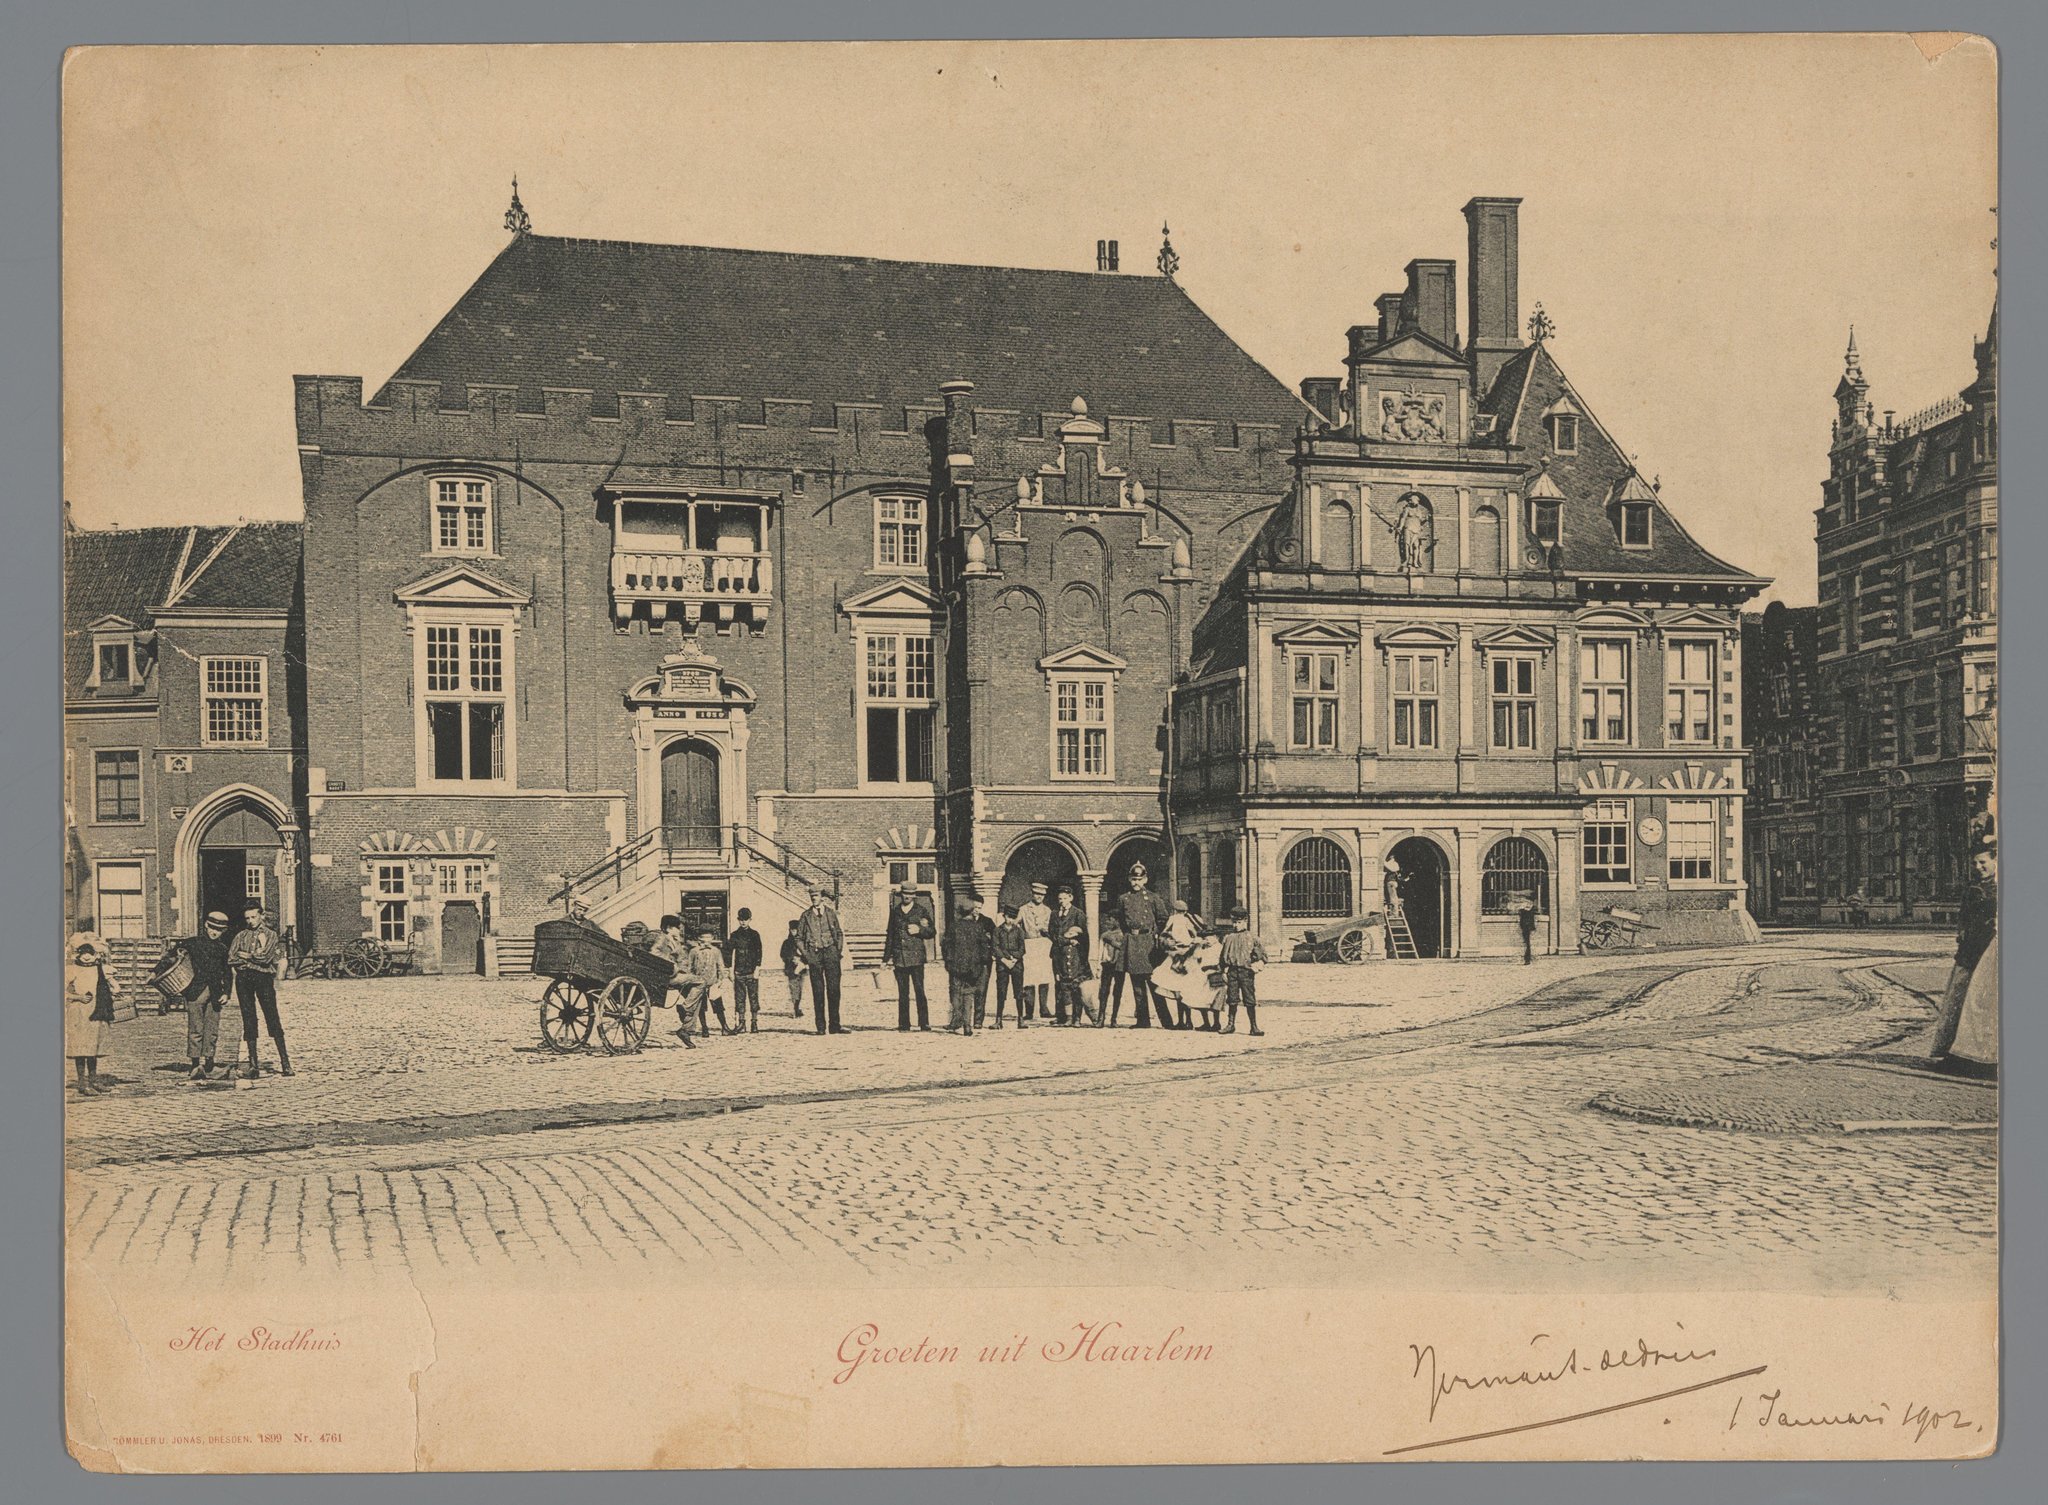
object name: ansichtkaart, prentbriefkaart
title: Gezicht op het Stadhuis in Haarlem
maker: Anonymous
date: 1899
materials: cardboard, paper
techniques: photograph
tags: townhall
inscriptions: annotation: ‘Naam van afzender en datering (1 januari 1902).’, address: ‘Den weled. gest. Heer W.B.G. Molkenboer Directeur Rijksnormaalschool voor Teekenonderwijzers. 50 Vossiusstraat Amsterdam’, inscription: ‘Reuzenkaart drukwerk’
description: Gelopen reuzenkaart, met gestempelde postzegel op verso.